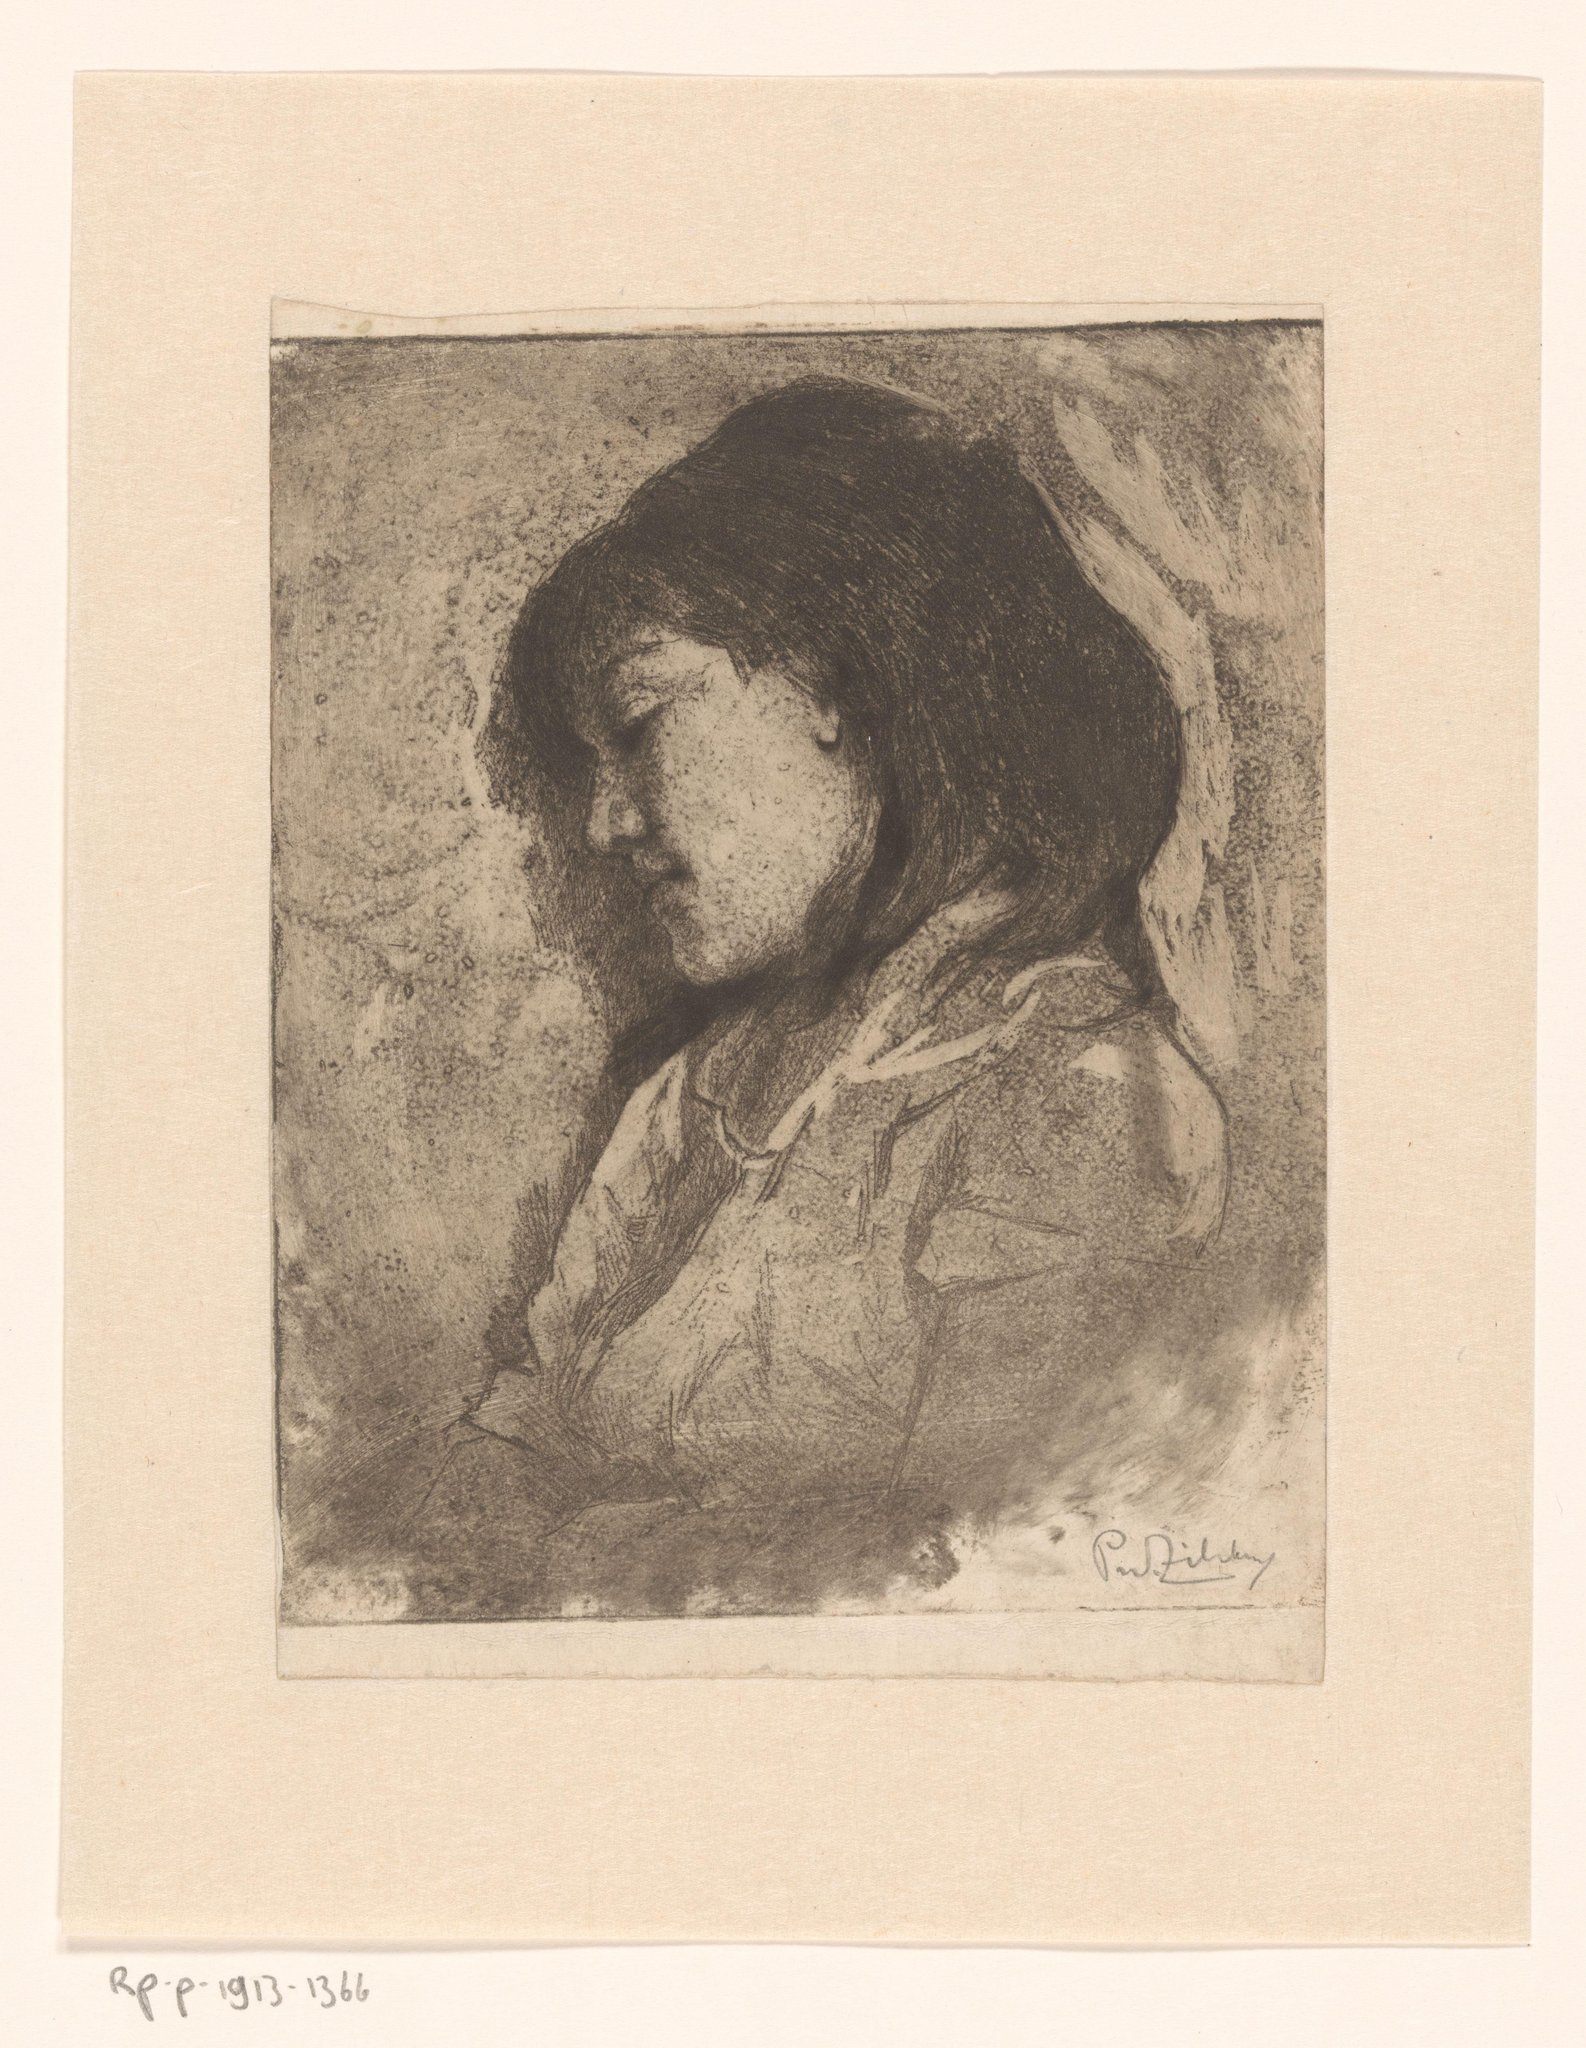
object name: print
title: Slapend meisje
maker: philip zilcken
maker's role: draughtsman, painter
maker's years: 1857-1930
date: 1867-1913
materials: paper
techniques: aquatint, drypoint, soft ground etching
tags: girl (child between toddler and youth), sleeping; unconsciousness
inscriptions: collector's mark: Lugt 2233